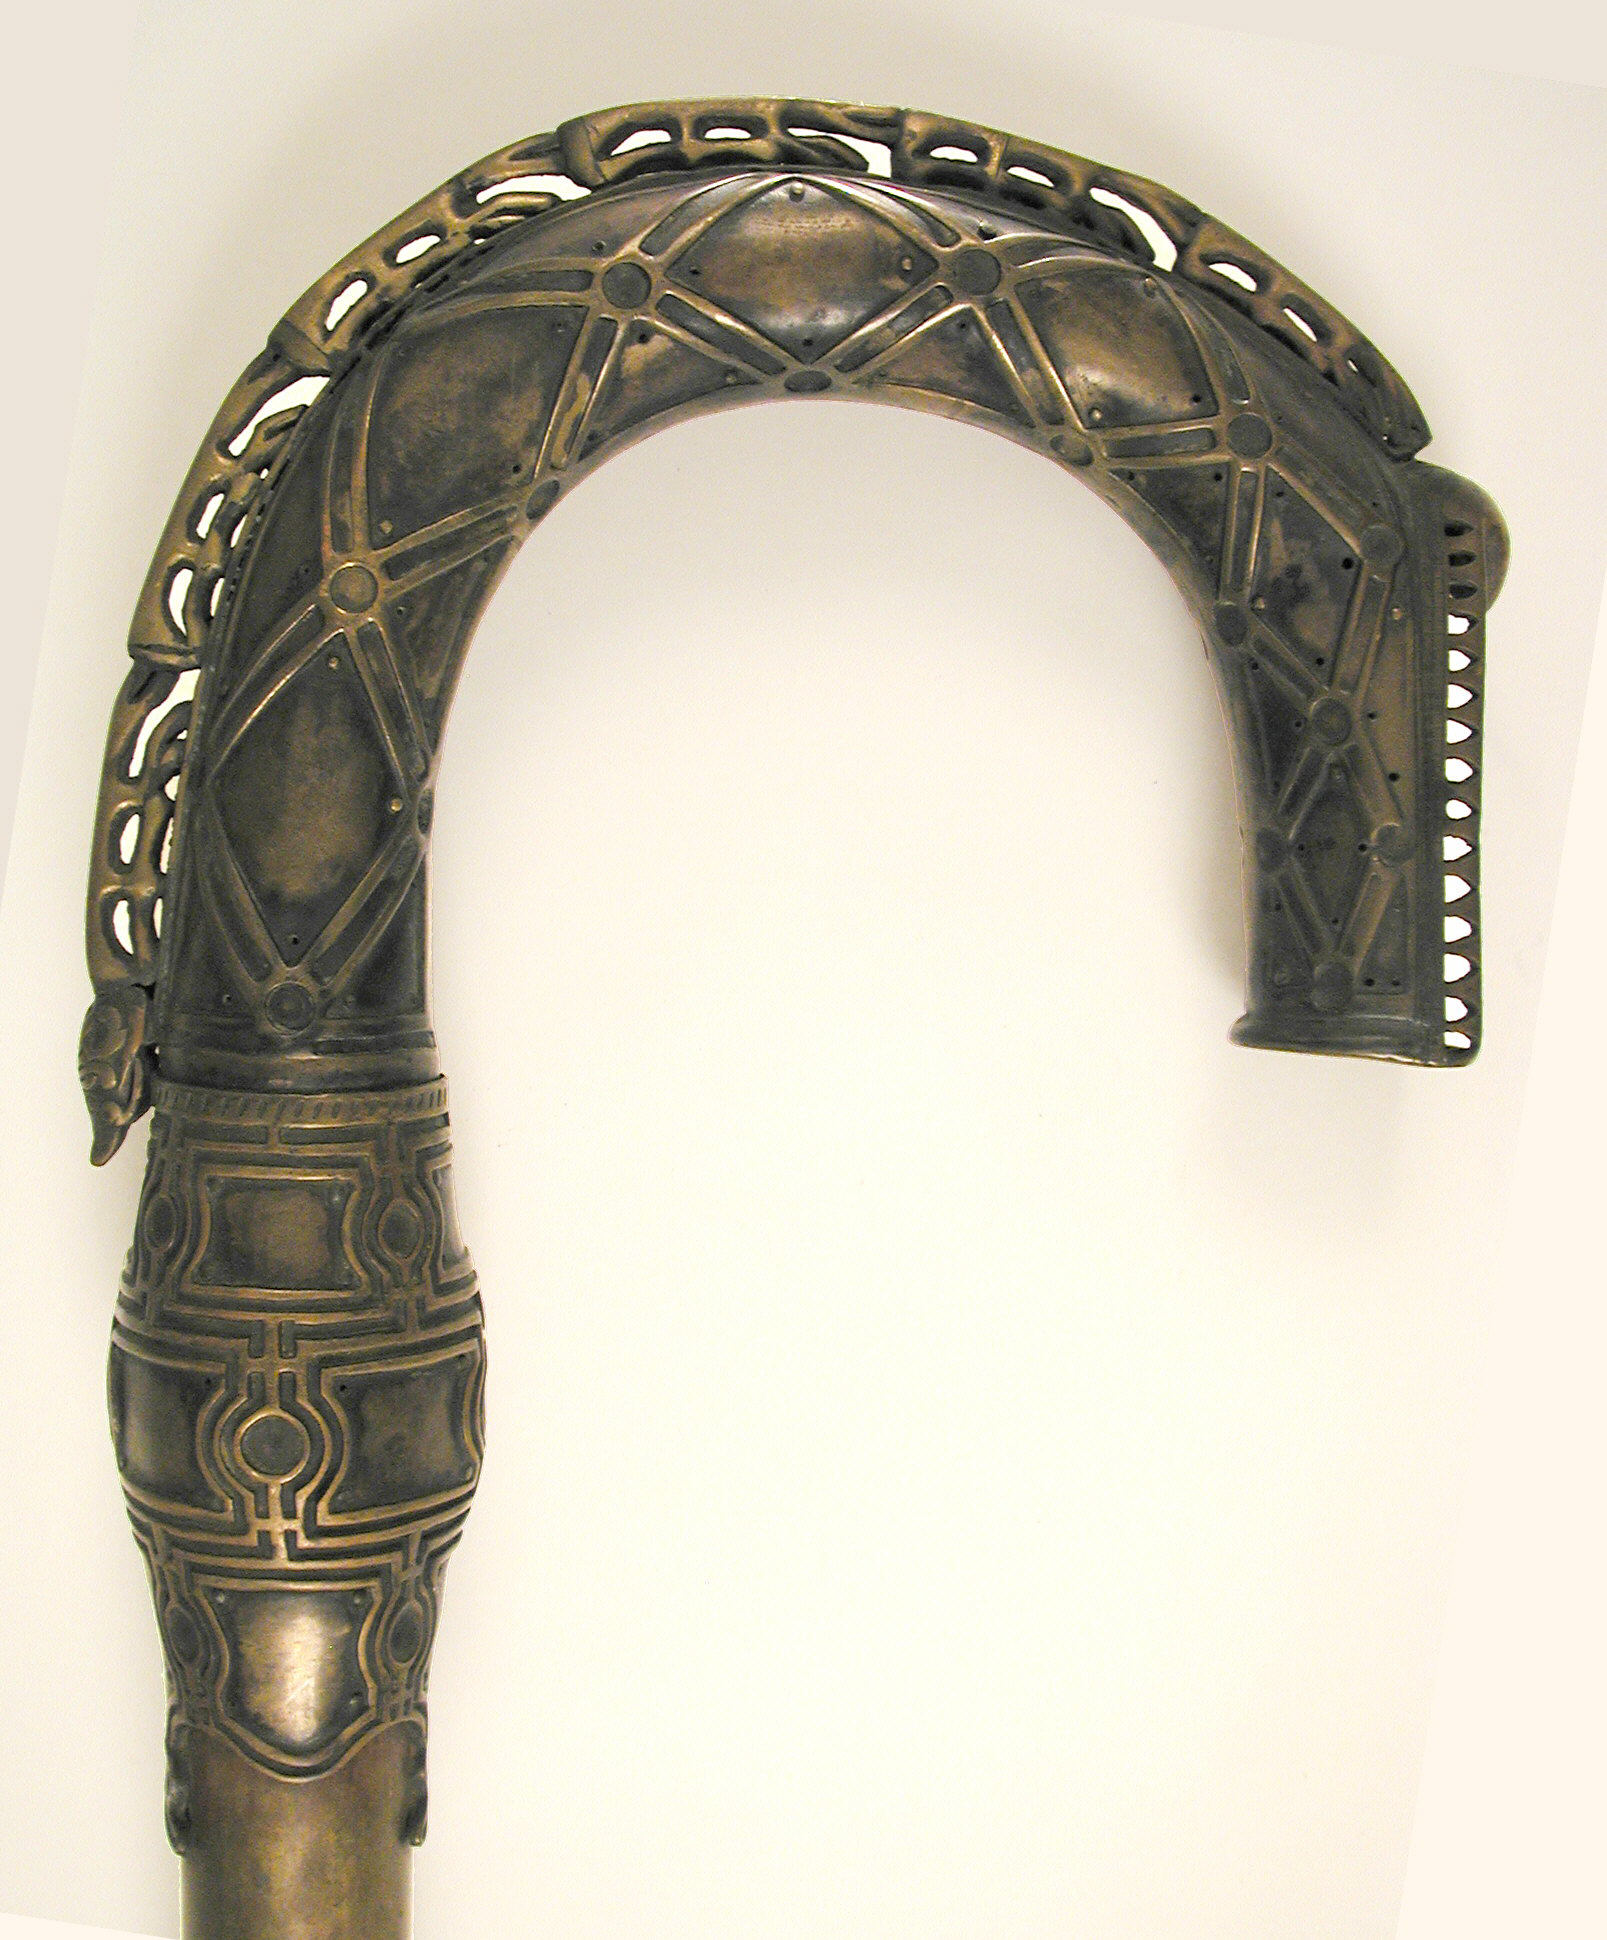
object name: crozier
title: Crozier of Dysert O'Dea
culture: irish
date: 1901-1933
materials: bronze, enamel, gold, silver